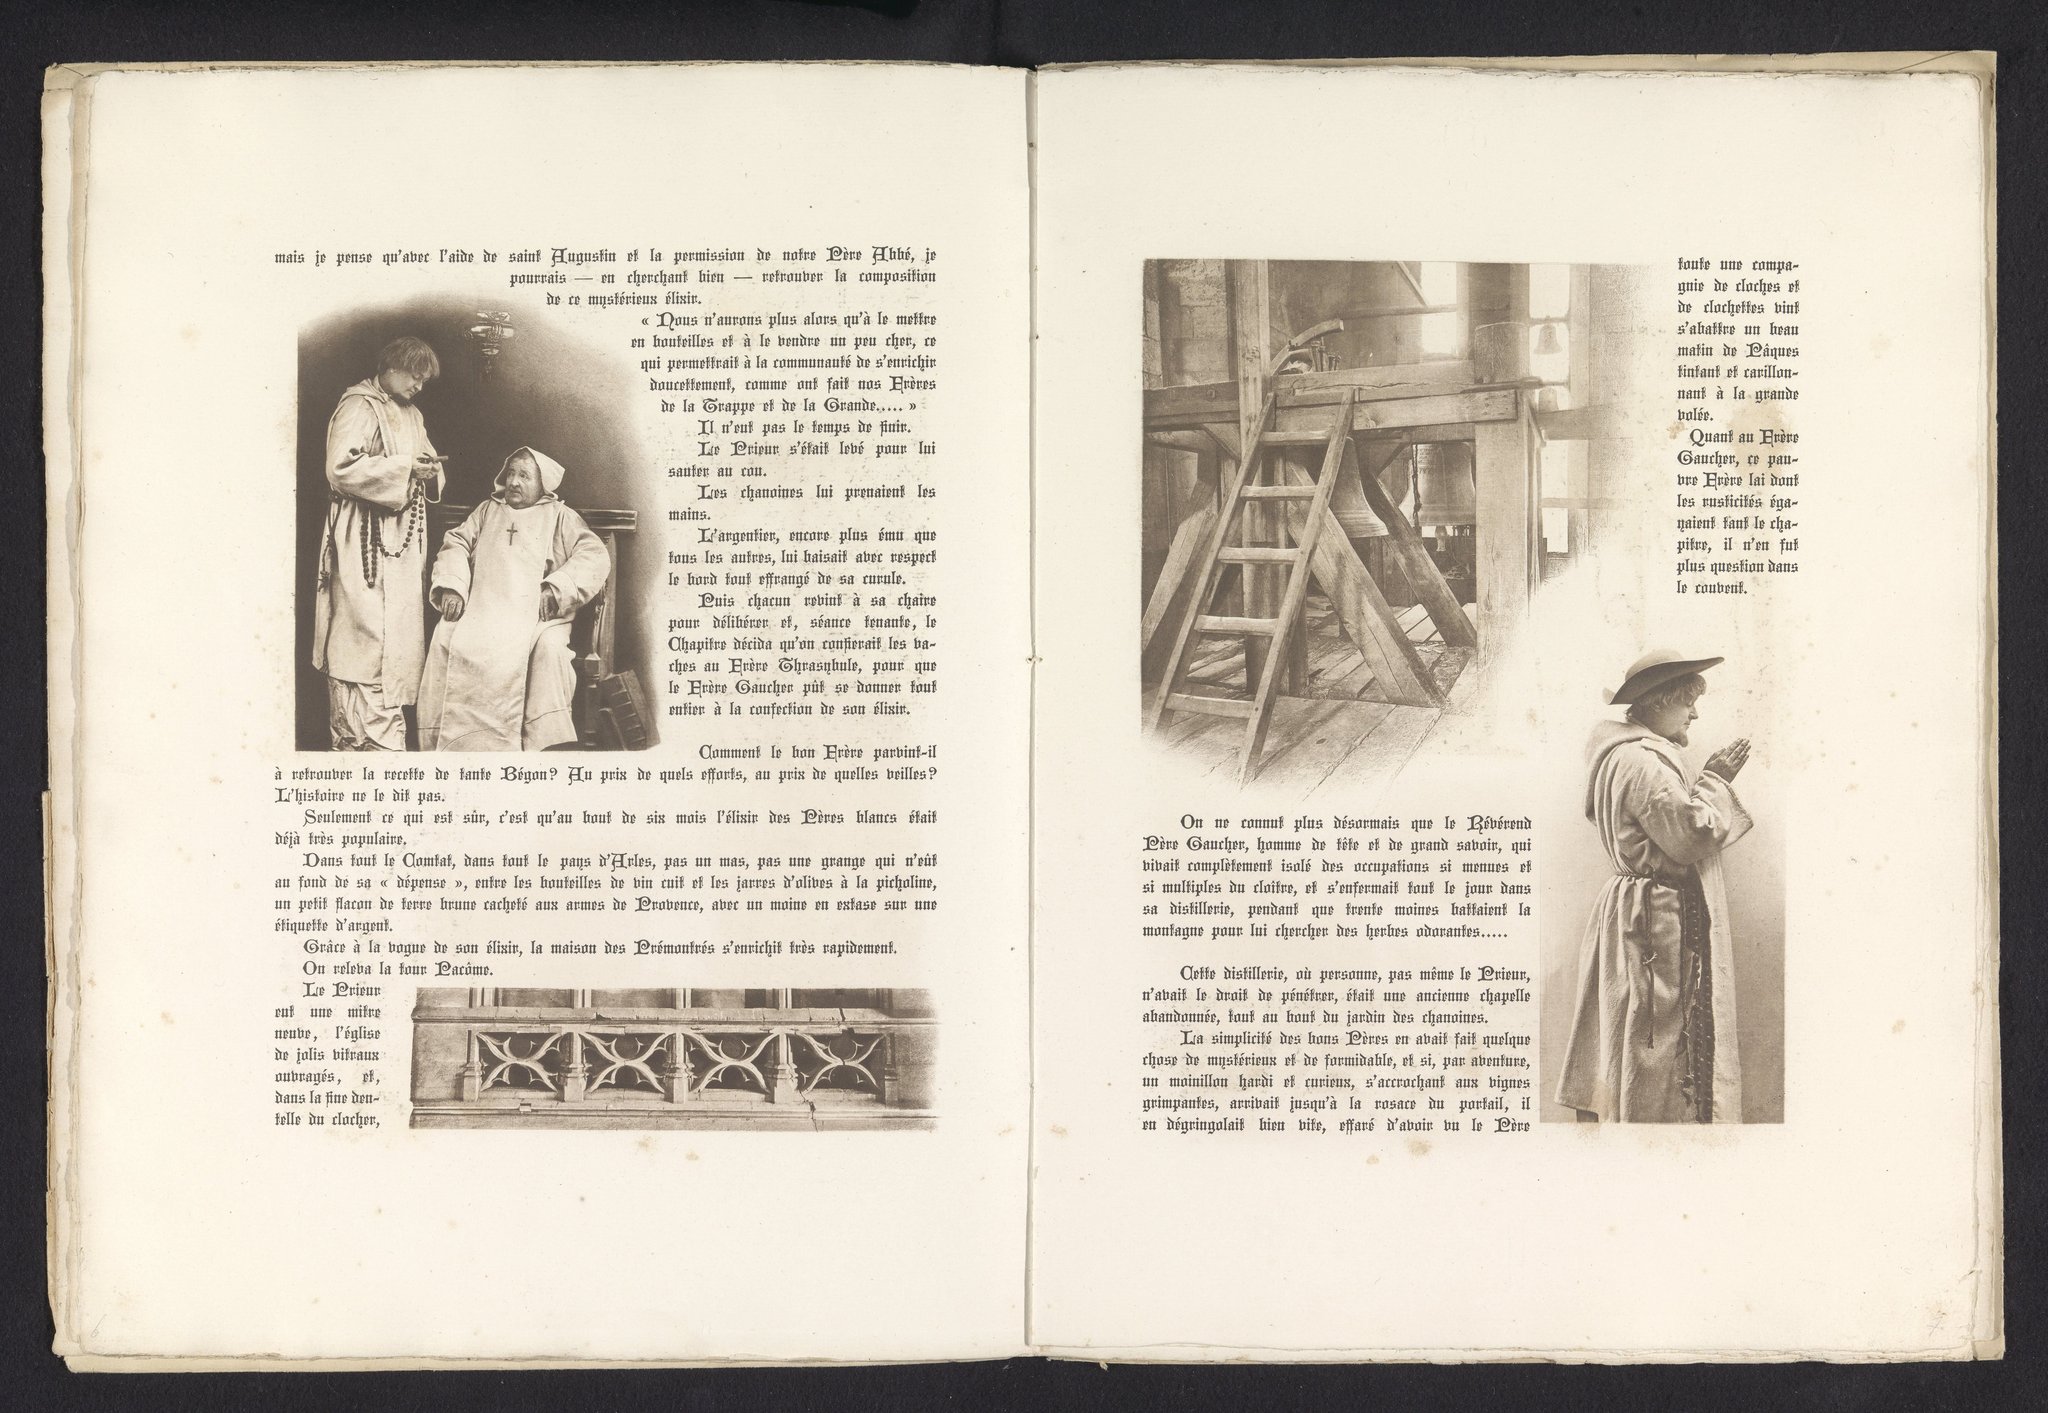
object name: photomechanical print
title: Twee monniken en een geornamenteerd hek (vermoedelijk) in een kerk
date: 1885-1896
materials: paper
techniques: photoaquatint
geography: france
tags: abbot, fence, wall, paling, monk(s), friar(s), interior of church